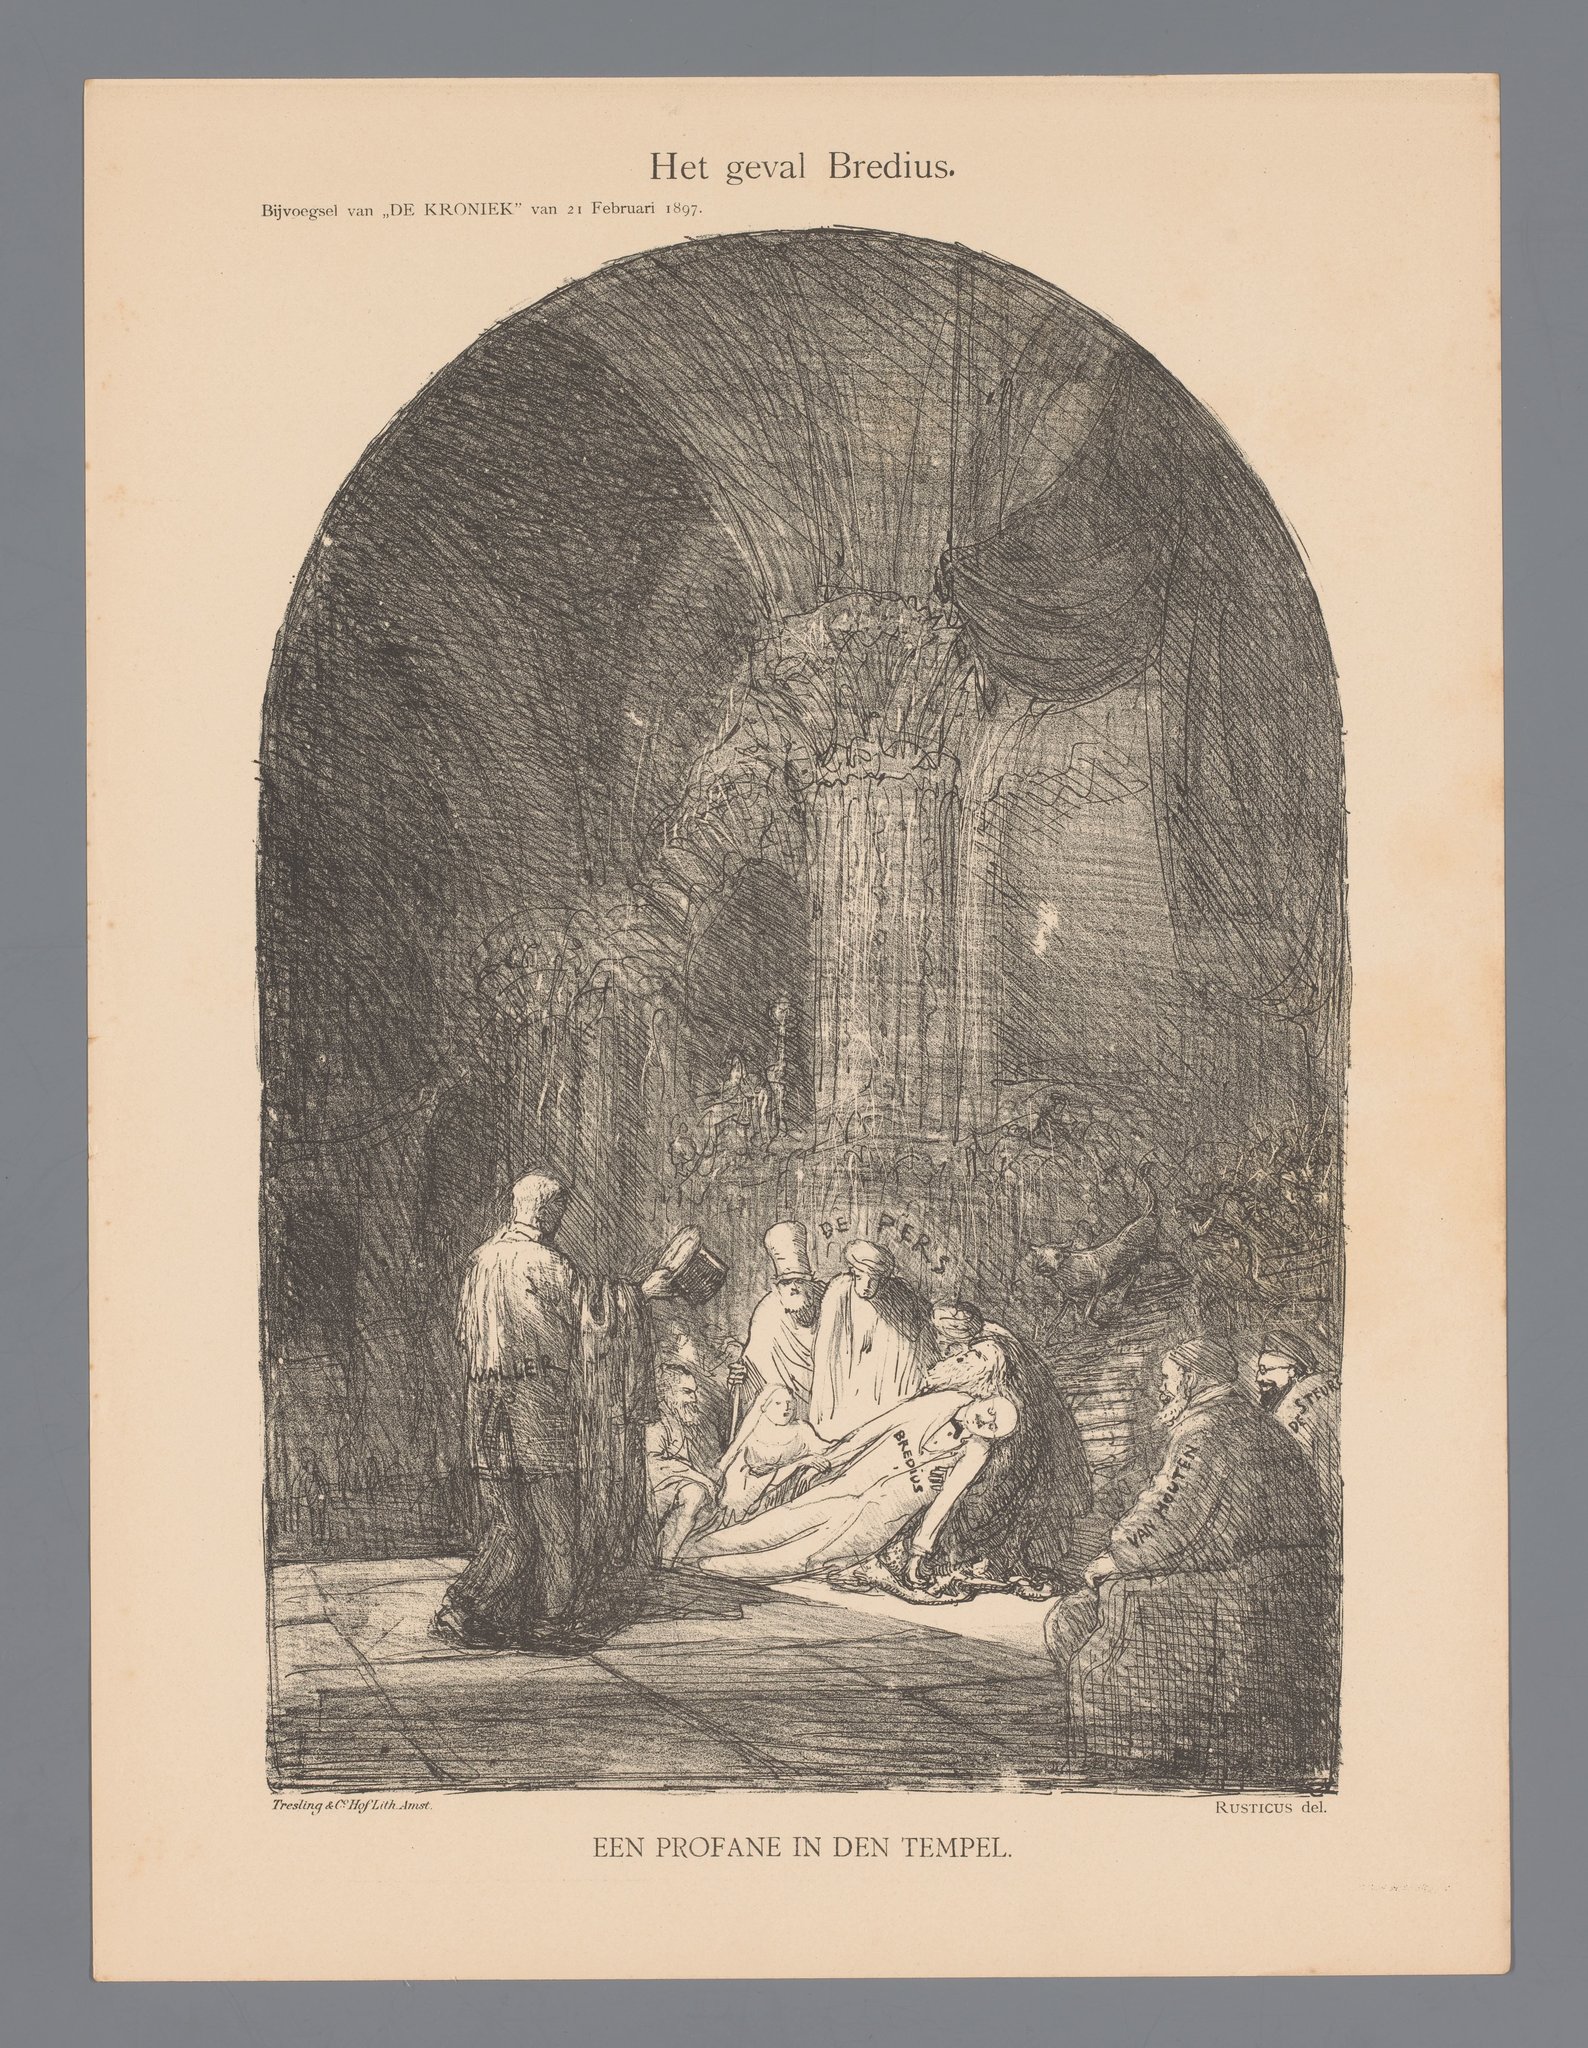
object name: cartoon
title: Een profane in den tempel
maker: marius bauer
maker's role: draughtsman, print maker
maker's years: 1867-1932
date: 1897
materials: paper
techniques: lithograph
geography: amsterdam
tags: maastricht, print maker, jonkheer victor eugène louis de stuers, amsterdam, political caricatures and satires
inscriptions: date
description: Spotprent op de onenigheid tussen Abraham Bredius en Victor de Stuers inzake de benoeming van Waller in het Mauritshuis. Het lichaam van de dode Bredius beweend door de pers, links F.G. Waller met de hoed in de hand, rechts kijken De Stuers en minister van Houten toe.